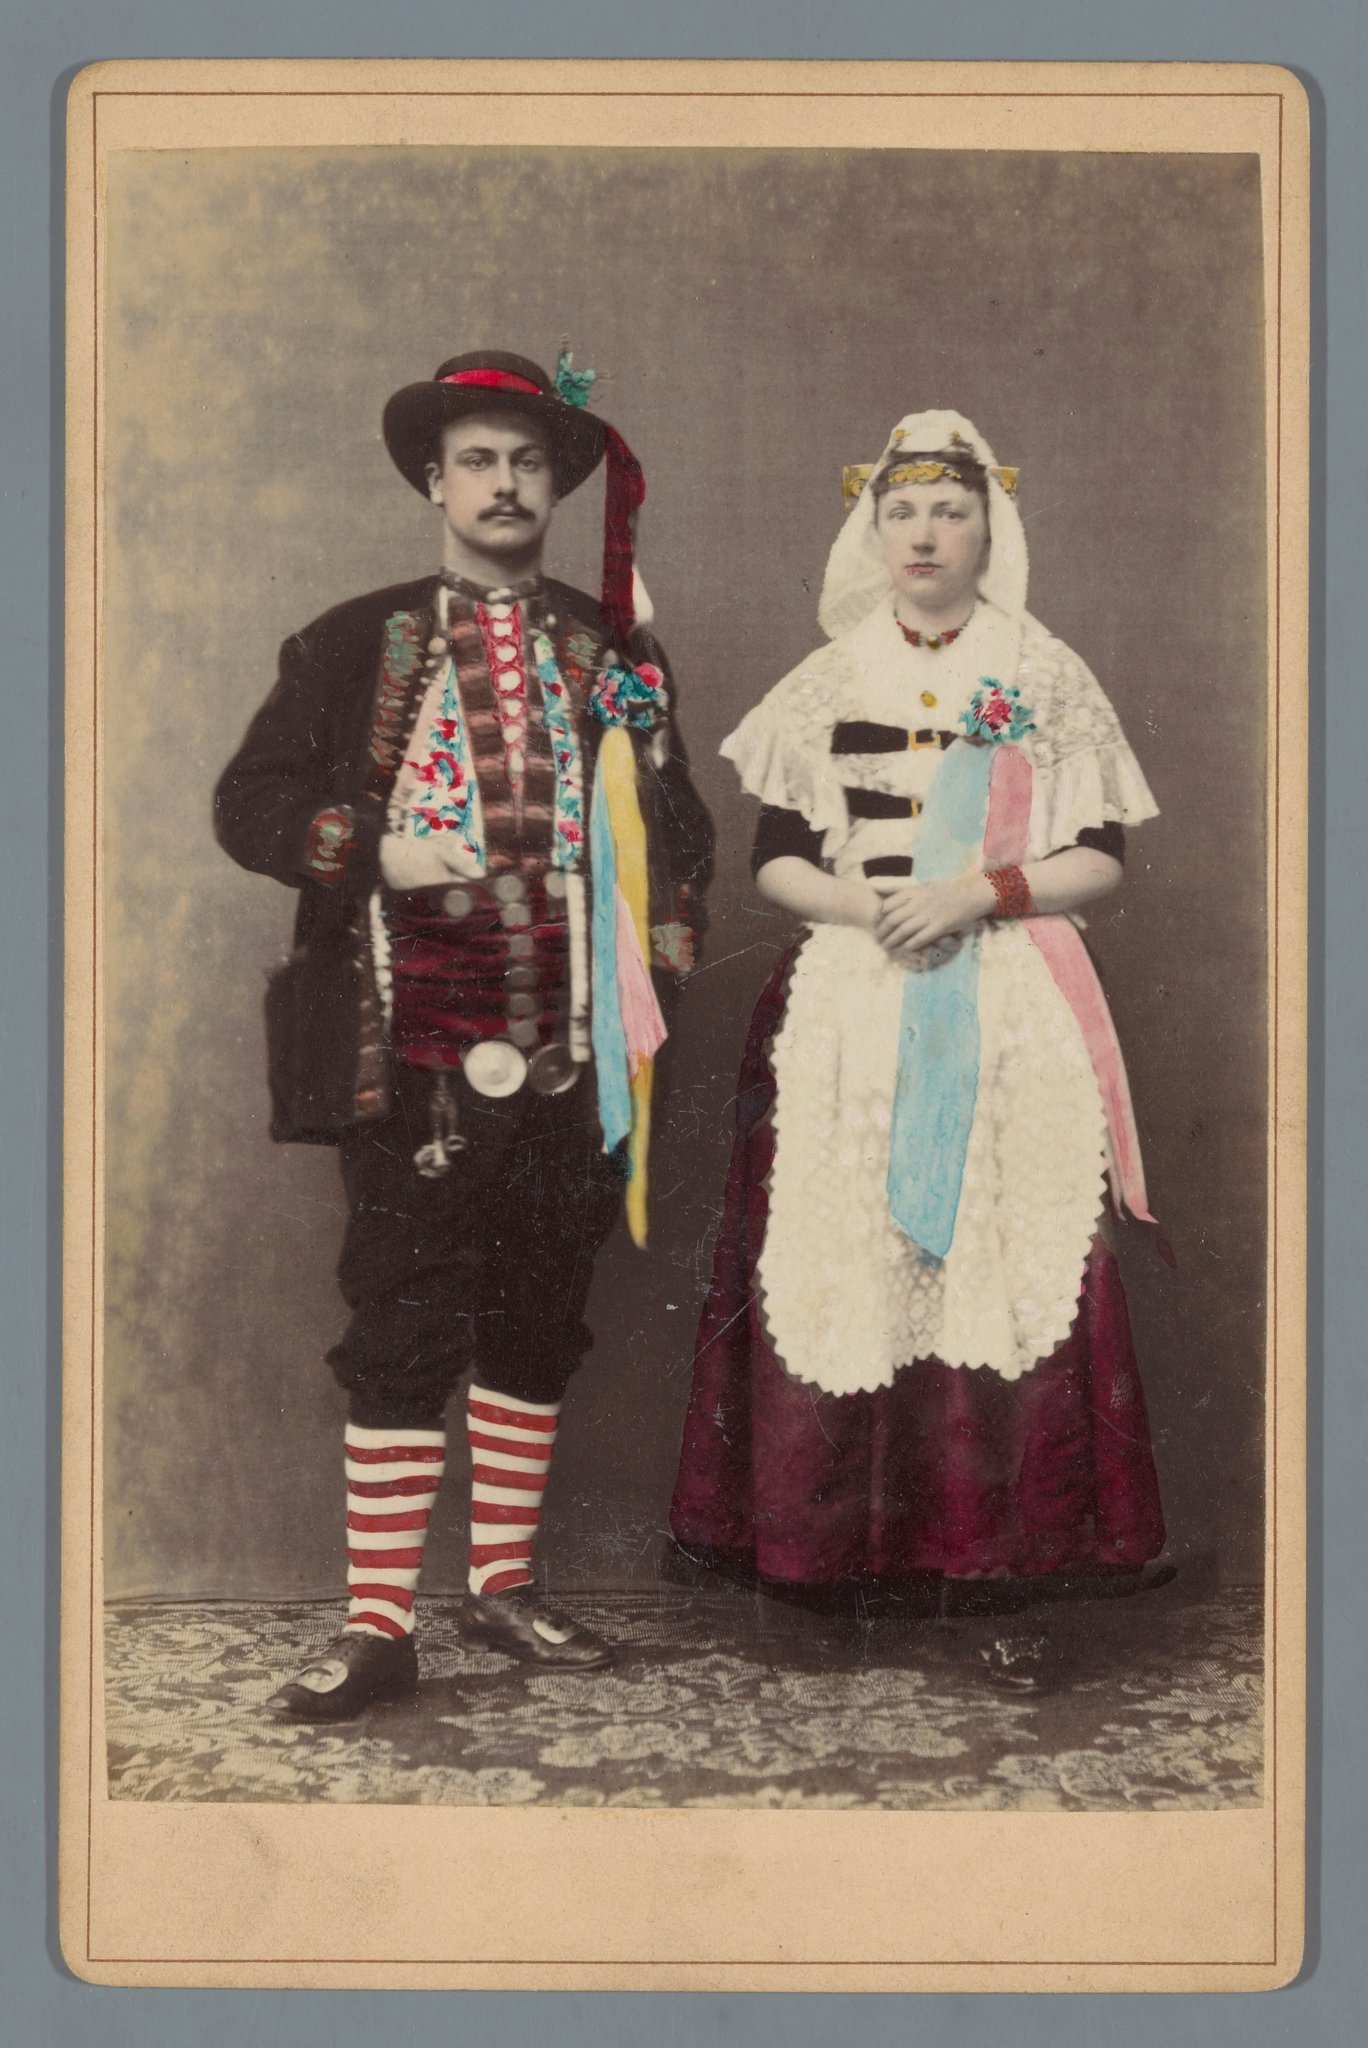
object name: cabinet photograph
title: Portret van een onbekende vrouw en man, vermoedelijk in klederdracht van Zuid-Beveland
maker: Anonymous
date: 1880-1900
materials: cardboard, photographic support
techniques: albumen print, hand coloring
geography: netherlands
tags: folk costume, regional costume